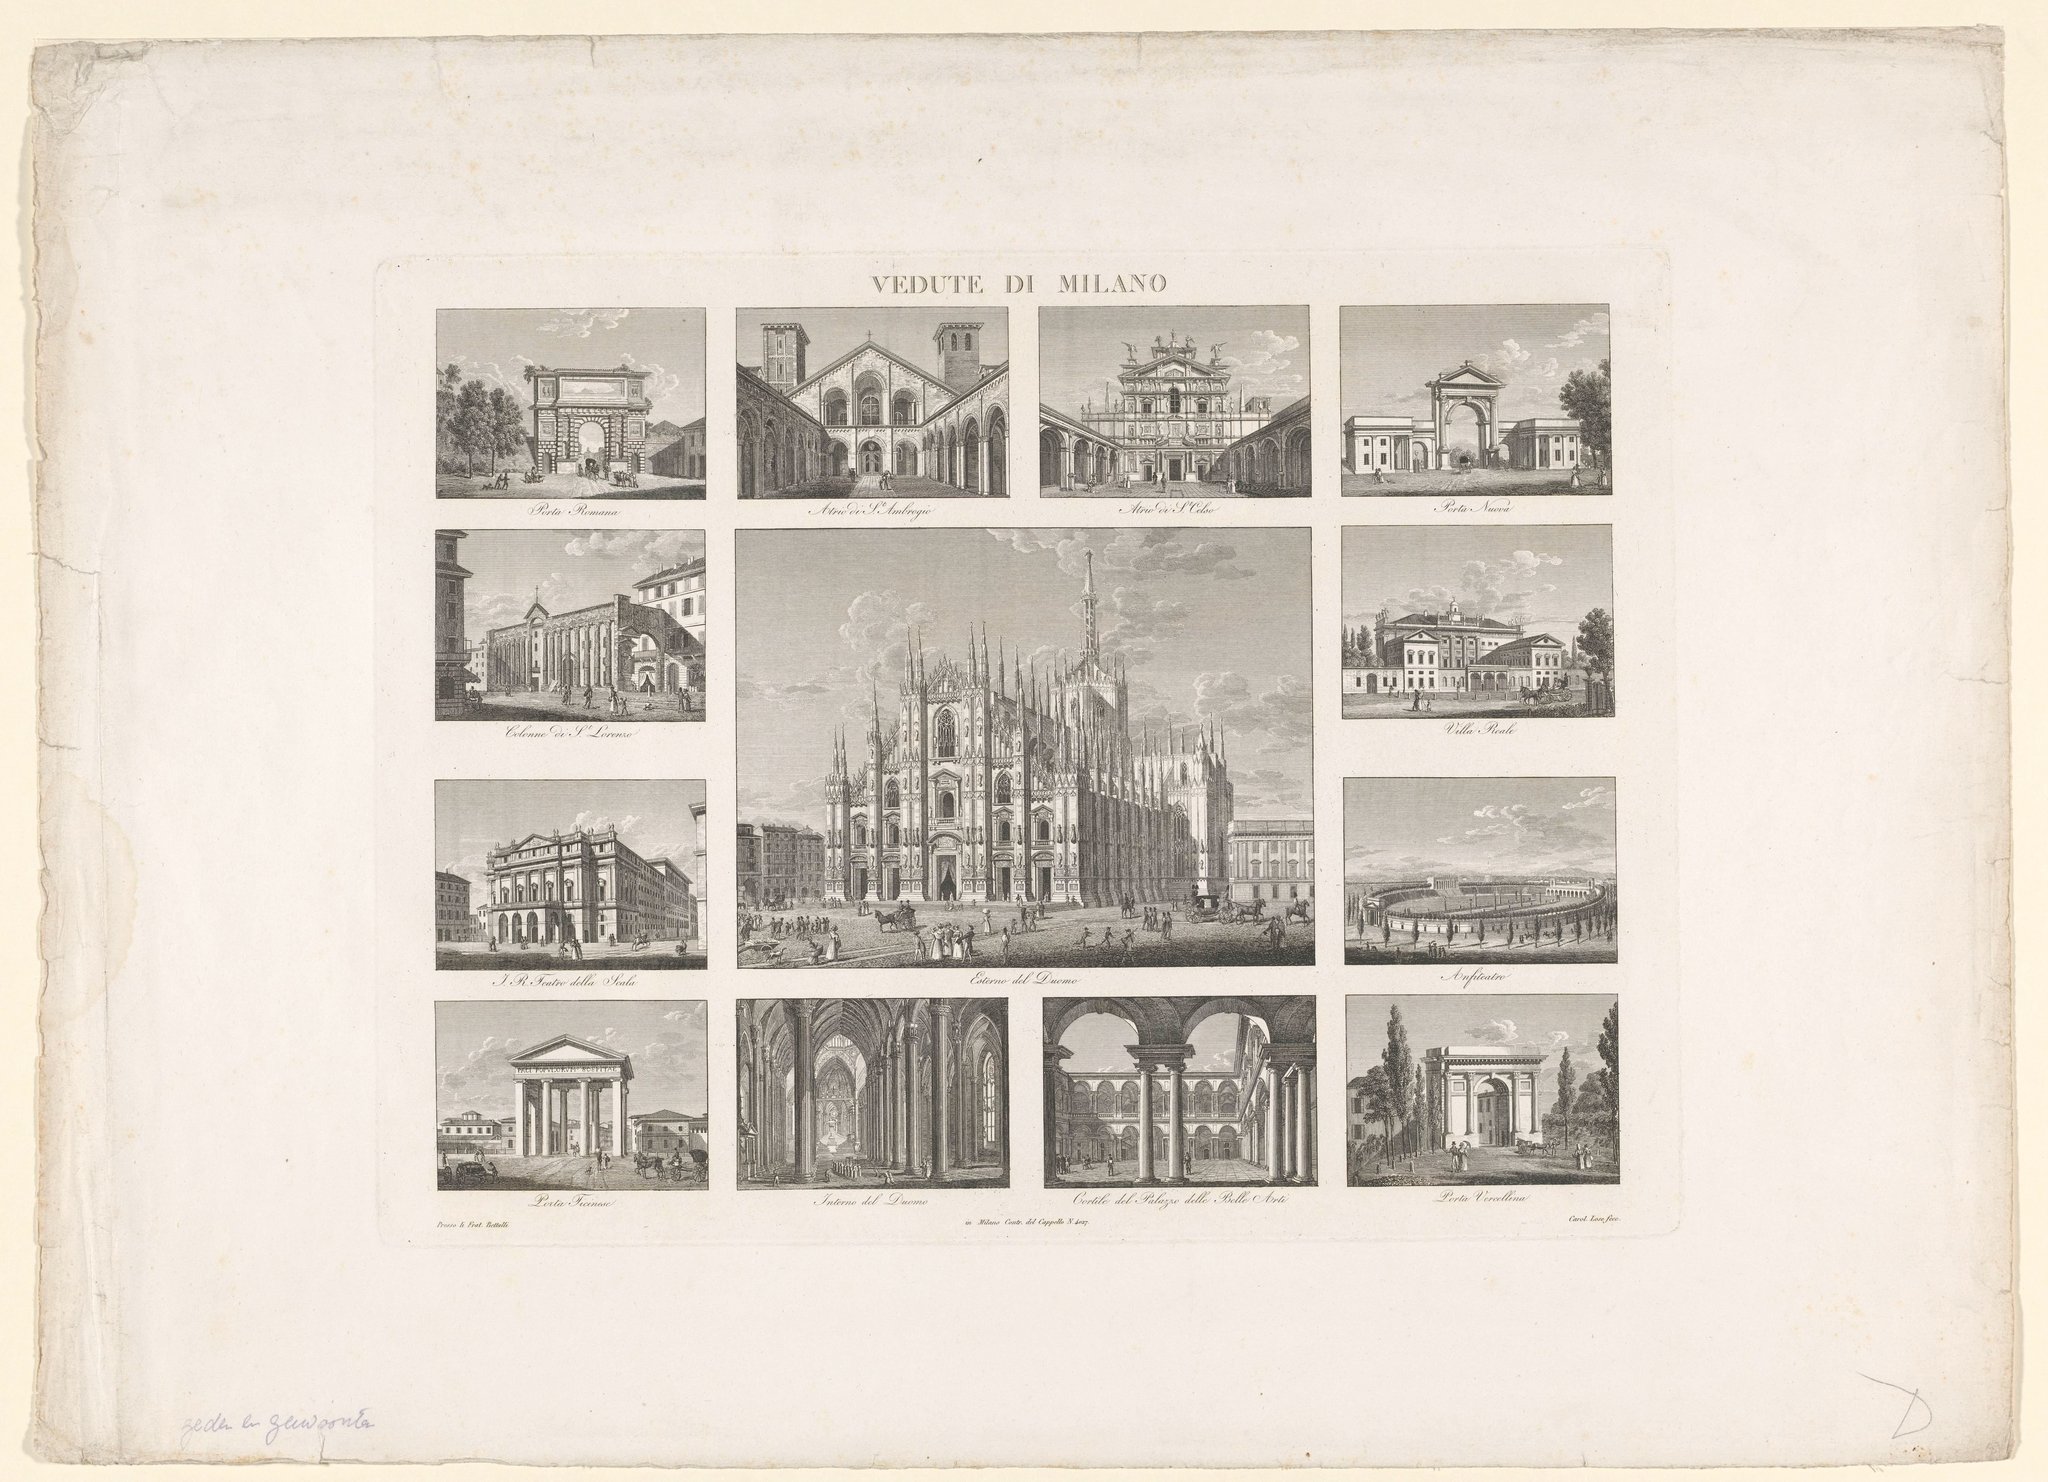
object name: print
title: Gezichten op belangrijke gebouwen en monumenten in Milaan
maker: caroline lose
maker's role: print maker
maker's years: 1784-1837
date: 1786-1850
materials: paper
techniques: etching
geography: milan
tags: city-view in general; 'veduta', triumphal arch, church (exterior)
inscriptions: collector's mark: Lugt 2228, collector's mark: ‘FB’